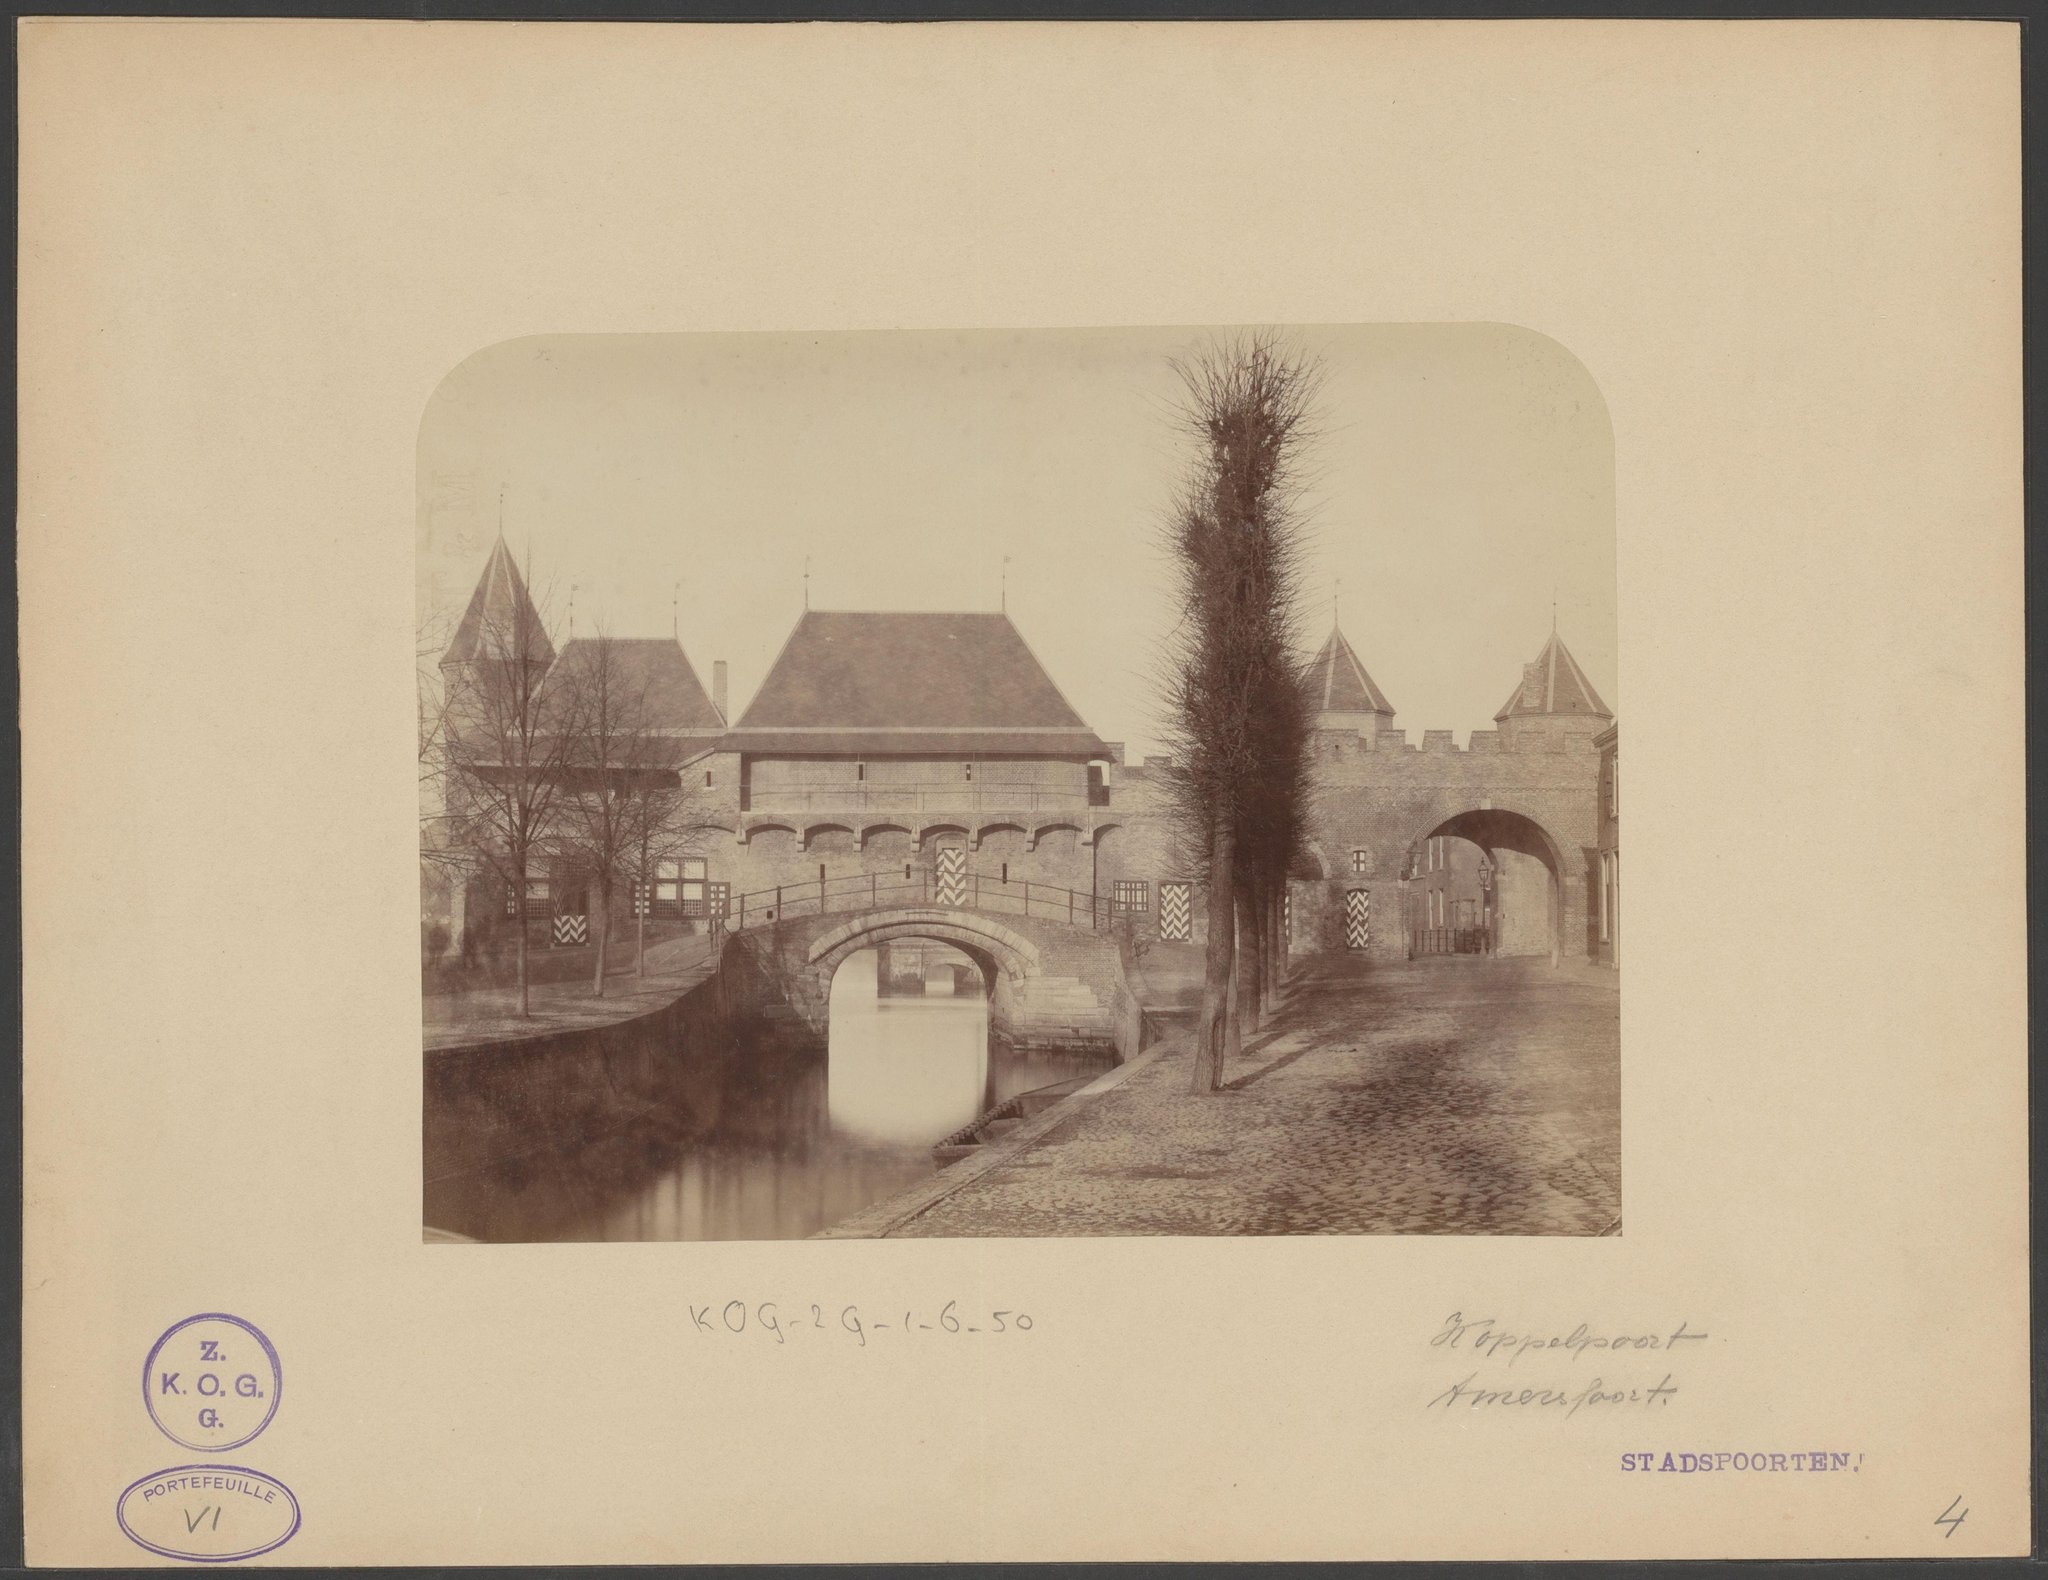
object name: photograph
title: Gezicht op de Koppelpoort te Amersfoort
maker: Anonymous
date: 1860-1900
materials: paper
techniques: albumen print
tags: city-gate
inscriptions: stamp, collector's mark: Lugt 1641, stamp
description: De Koppelpoort te Amersfoort is een combinatie van een land- en waterpoort. Onderwerpsrubrieken binnen de Atlas Zeden en Gewoonten: Krijgswezen, Stadspoorten.